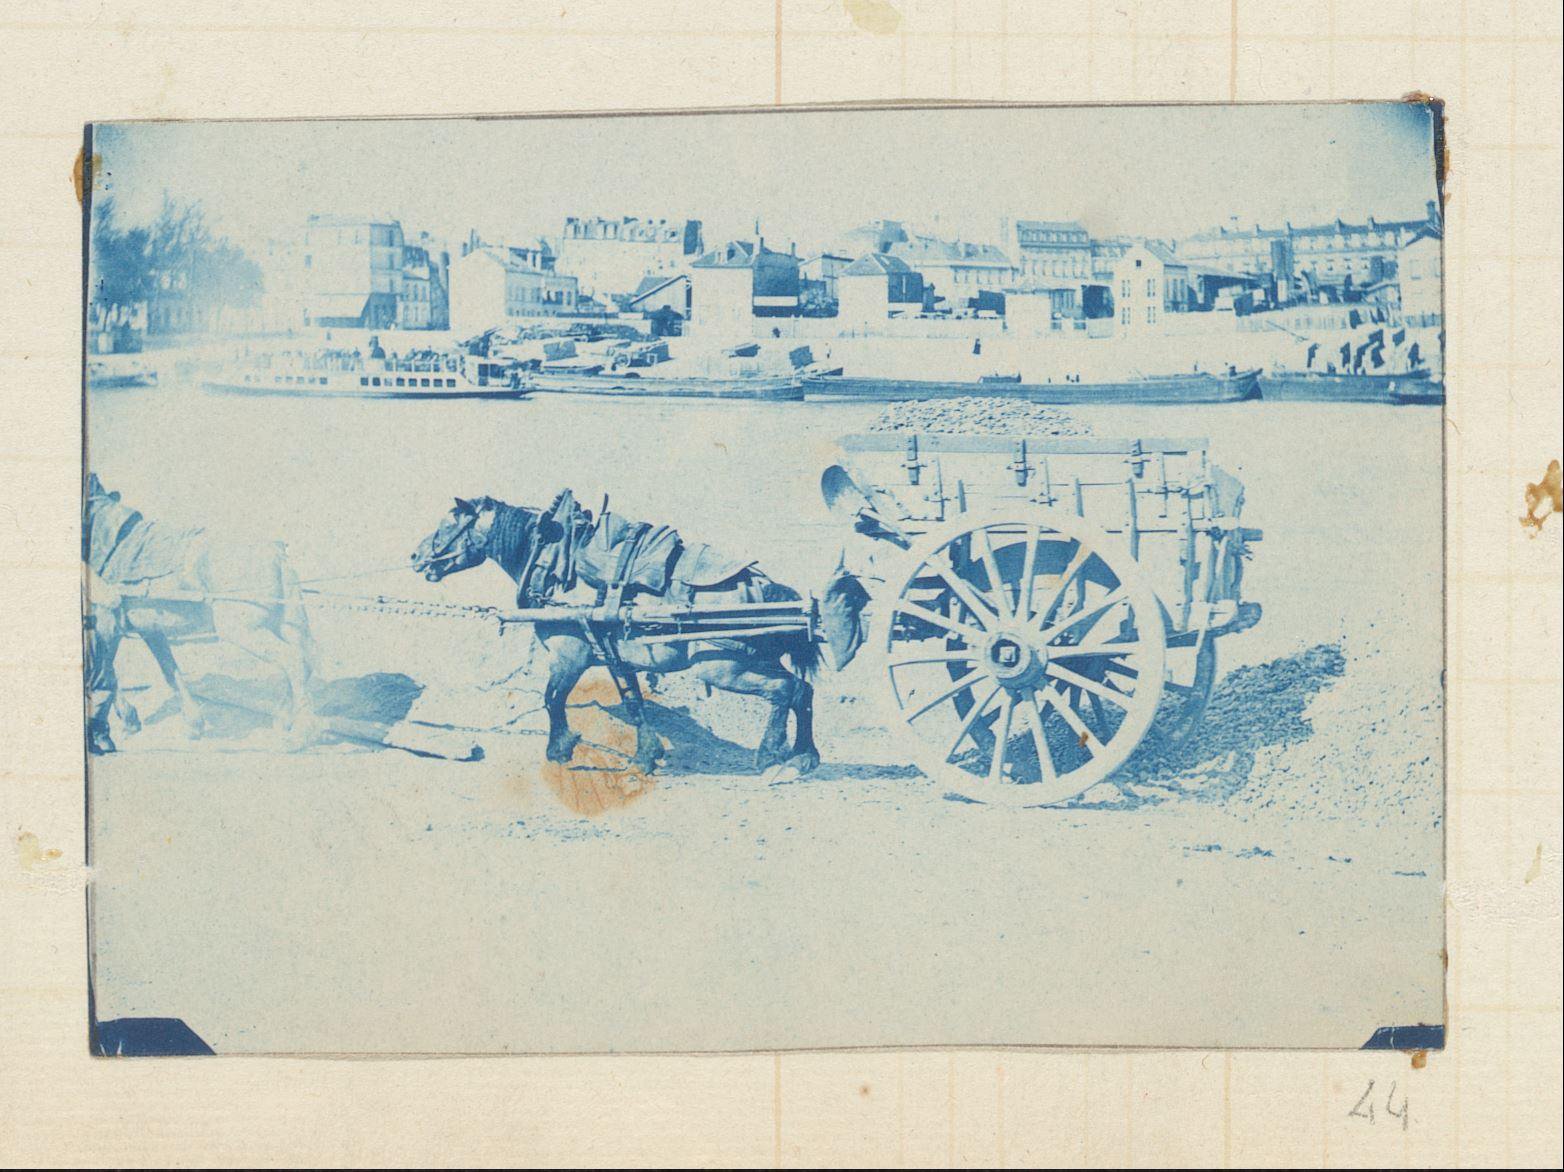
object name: photograph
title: Kar met twee paarden langs een rivier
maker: Anonymous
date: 1880-1900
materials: paper, photographic support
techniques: cyanotype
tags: two-wheeled, animal-drawn vehicle